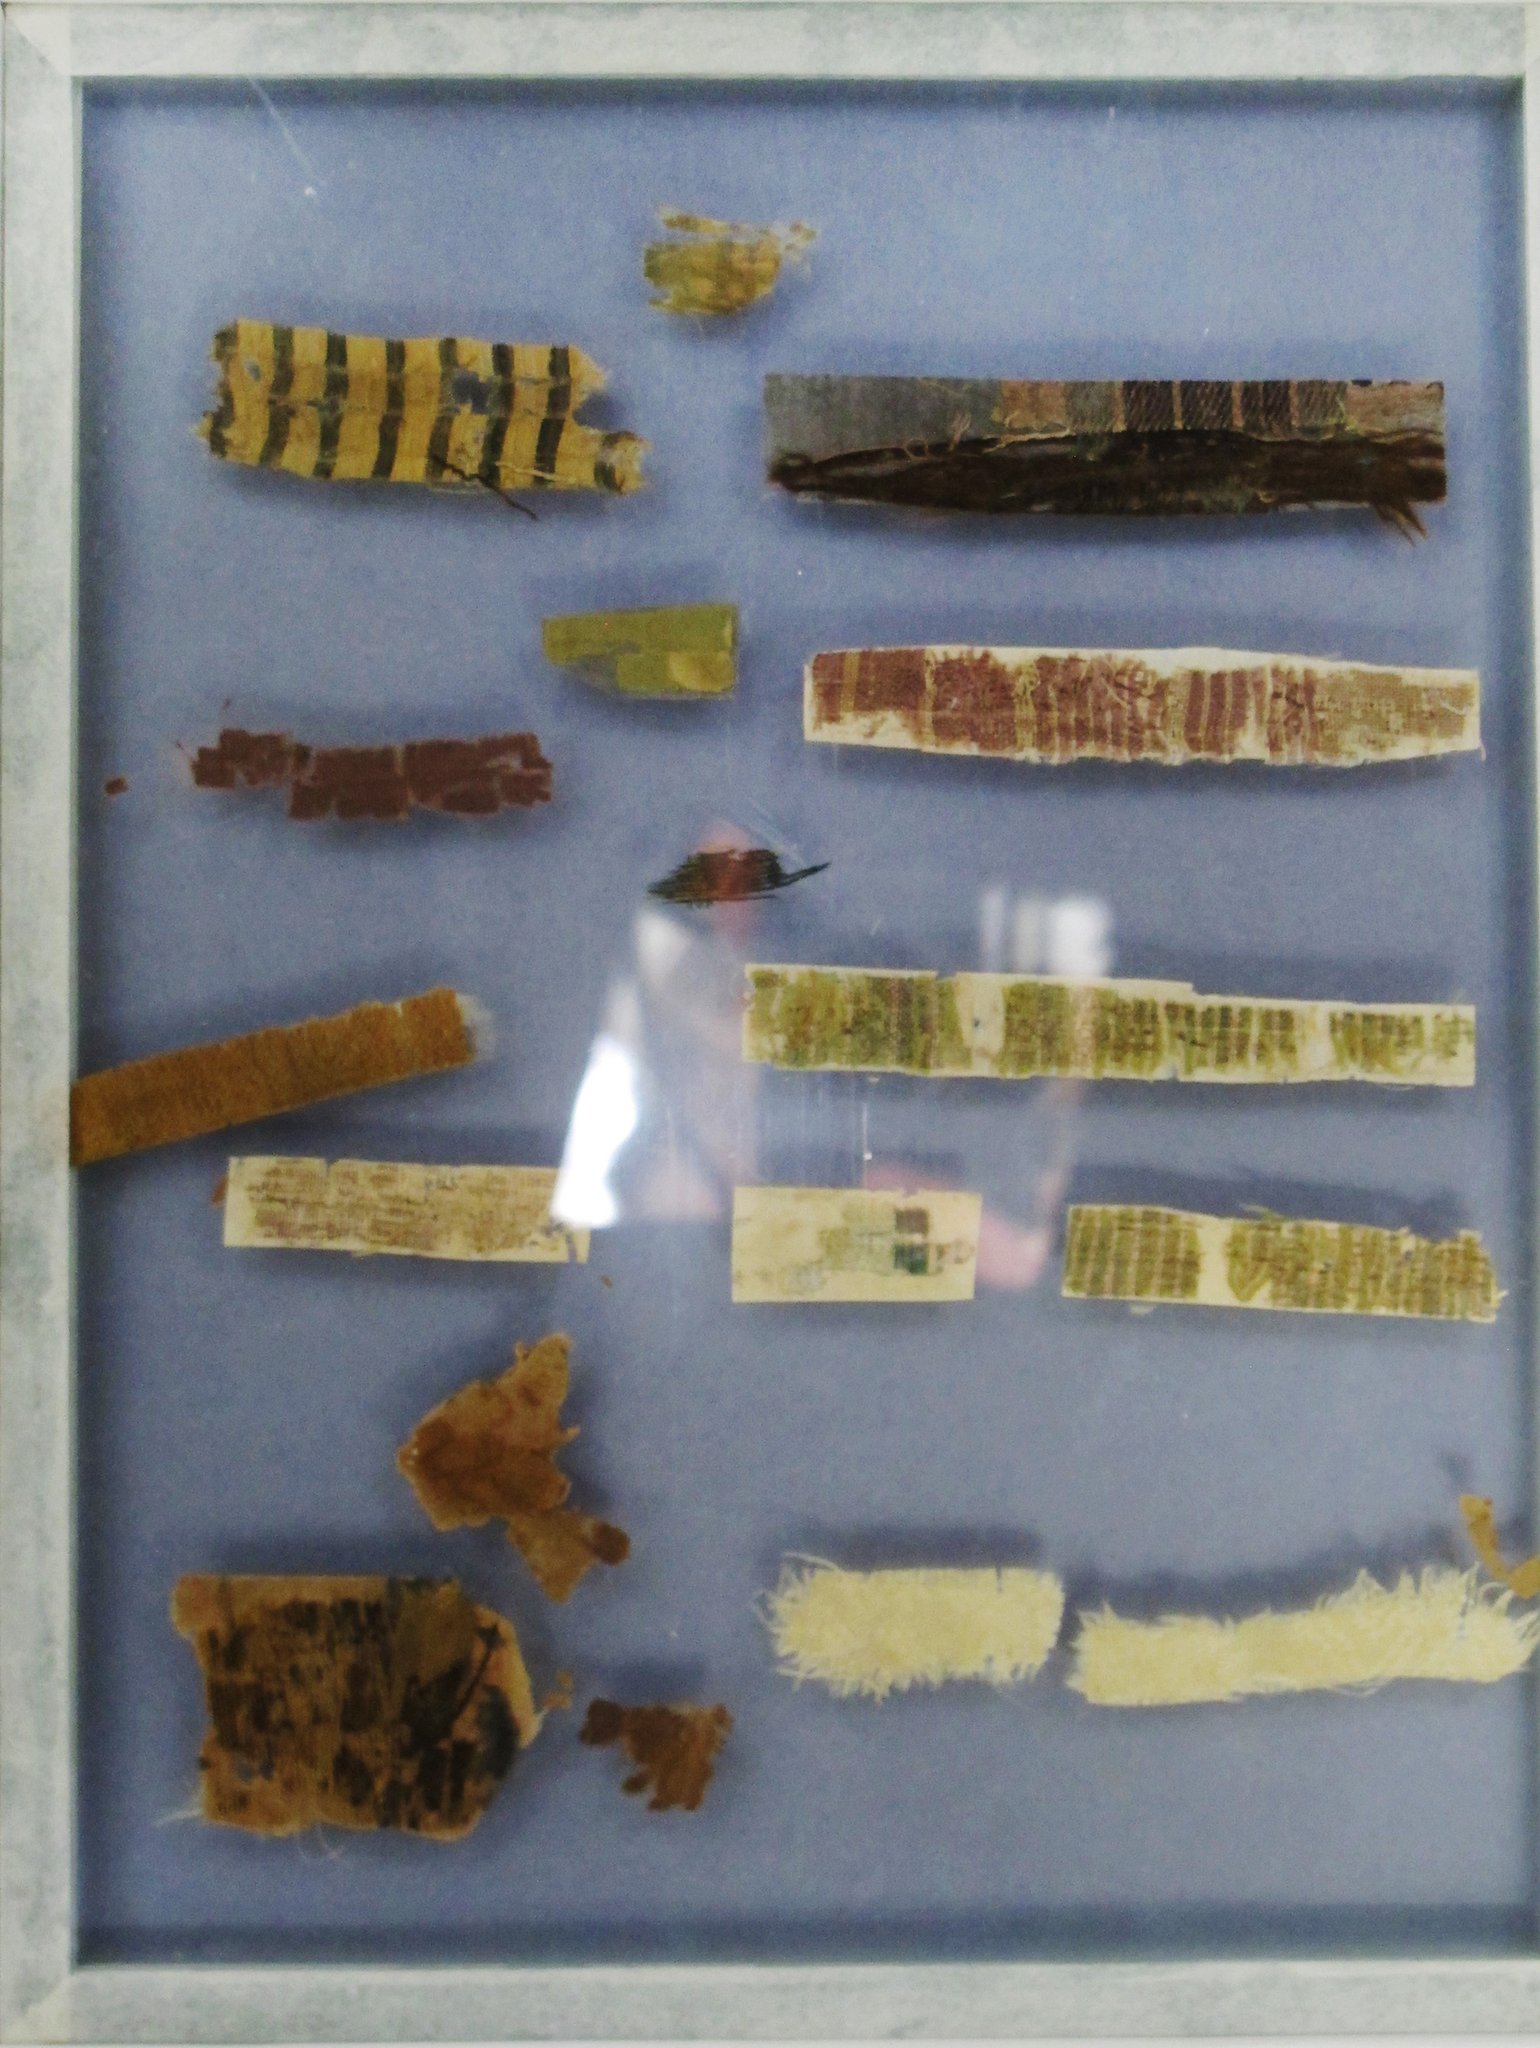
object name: fragment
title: Nineteen Fragments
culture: japanese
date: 701-800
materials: silk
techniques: brocade